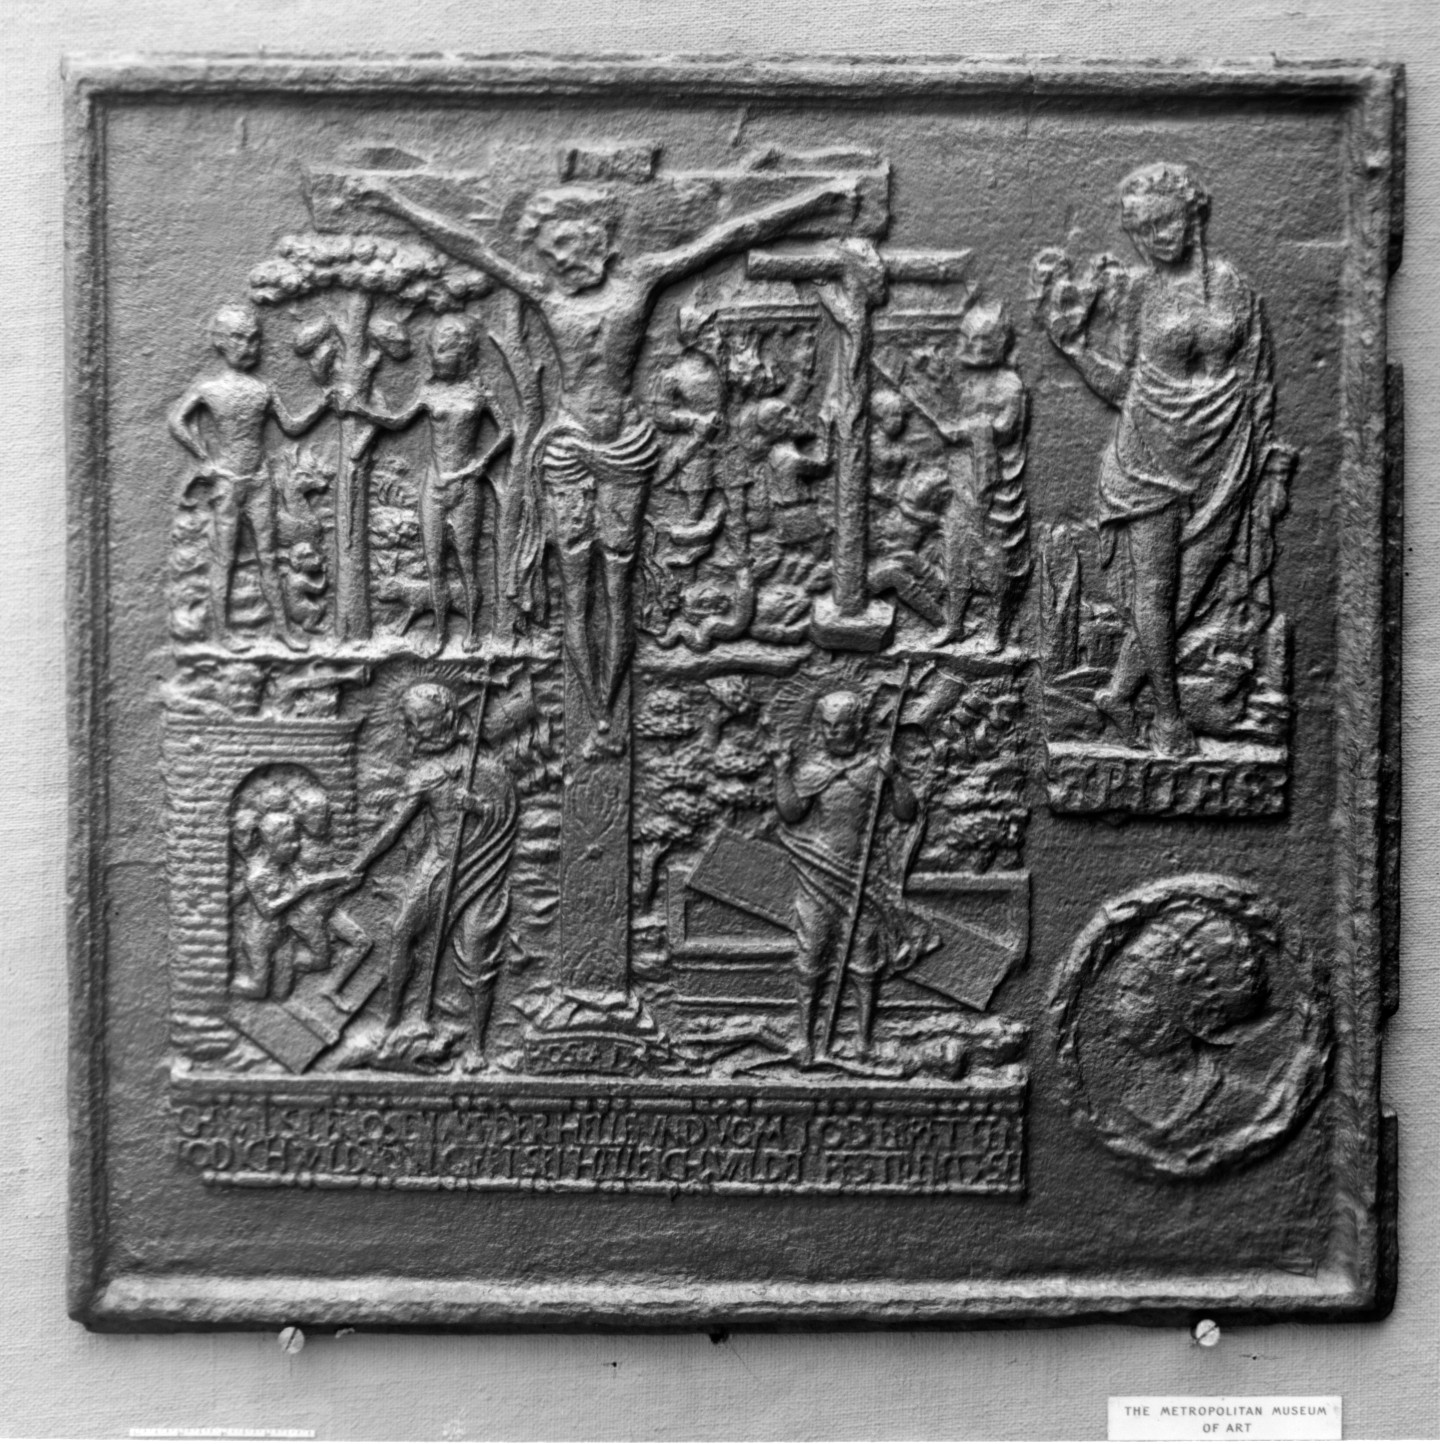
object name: stove plate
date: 1501-1600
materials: iron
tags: men,female nudes,jesus,crucifixion